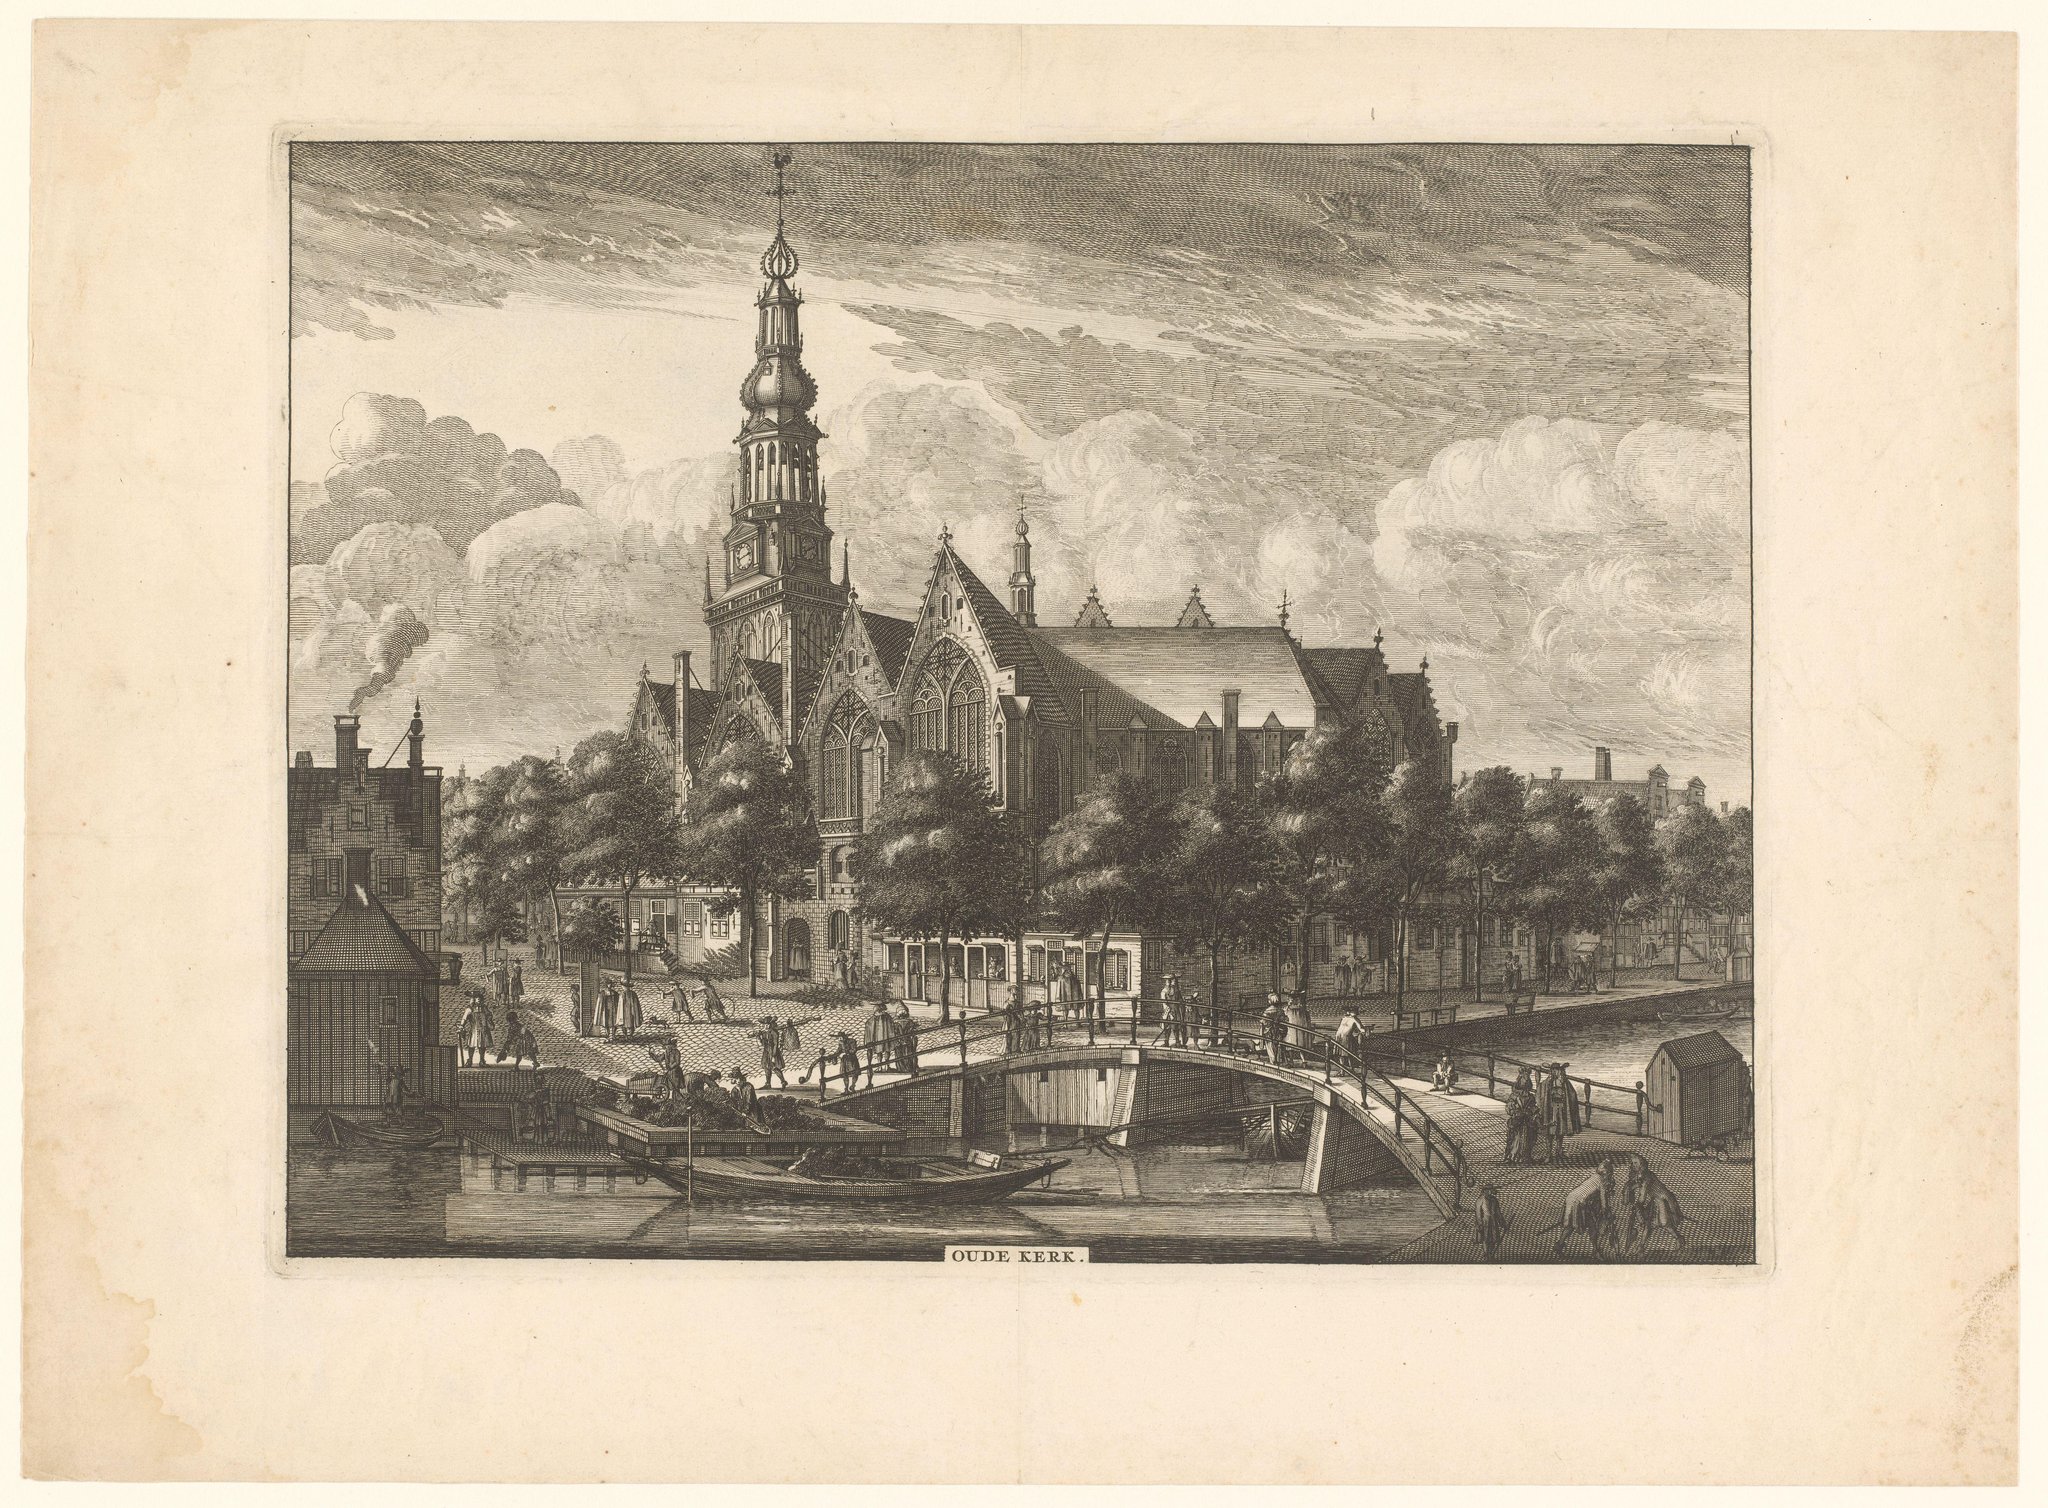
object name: print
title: Gezicht op de Oude Kerk te Amsterdam vanaf de Oudezijds Voorburgwal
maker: Anonymous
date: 1726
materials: paper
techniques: etching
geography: netherlands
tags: bridge in city across river, canal, etc. (+ city(-scape) with figures, staffage), church (exterior)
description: Prent in deze staat waarschijnlijk uit: Commelin, Caspar. Beschryvinge van Amsterdam, zynde een naukeurige verhandelinge van desselfs eerste oorspronk uyt (…). Amsterdam: Andries van Damme et al., 1726. Eerdere staat in uitgave van dit werk uit 1694.